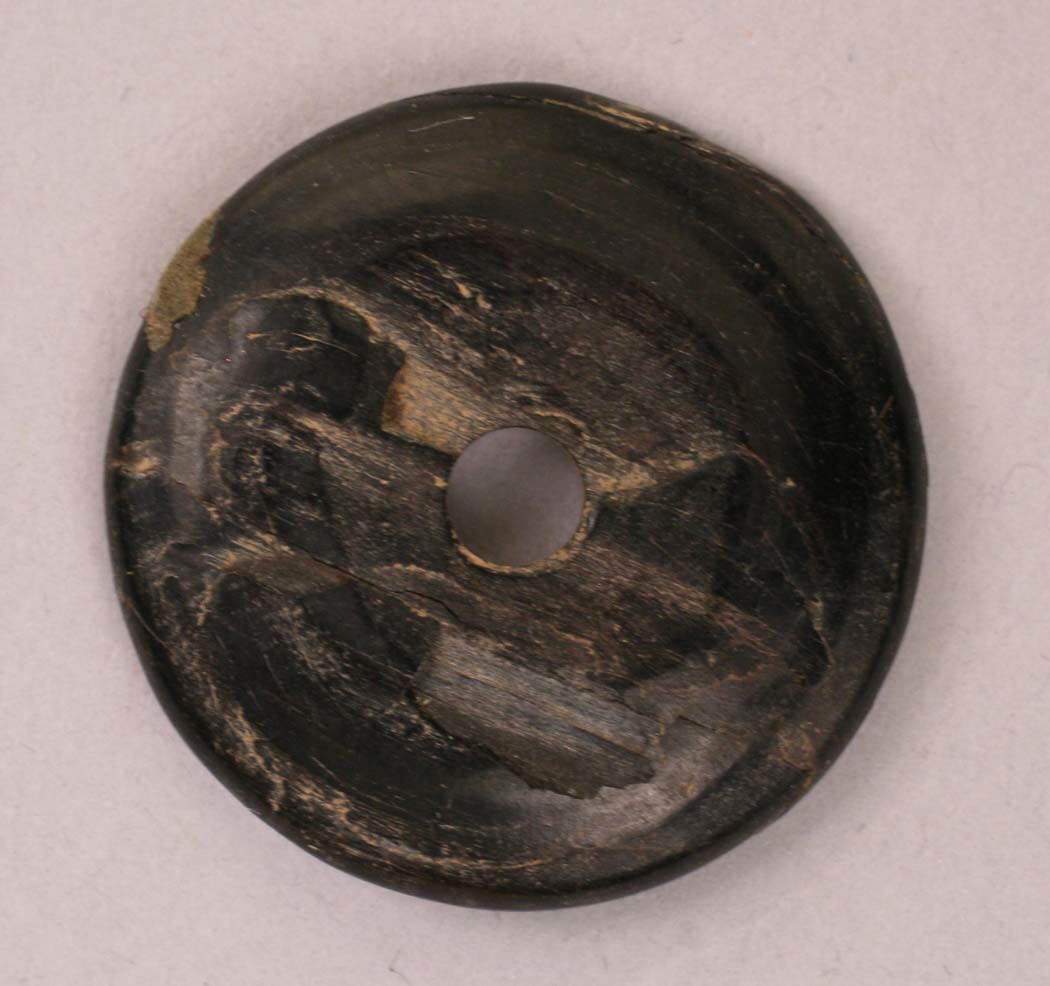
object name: button or bead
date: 801-1100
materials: stone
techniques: carving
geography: iran